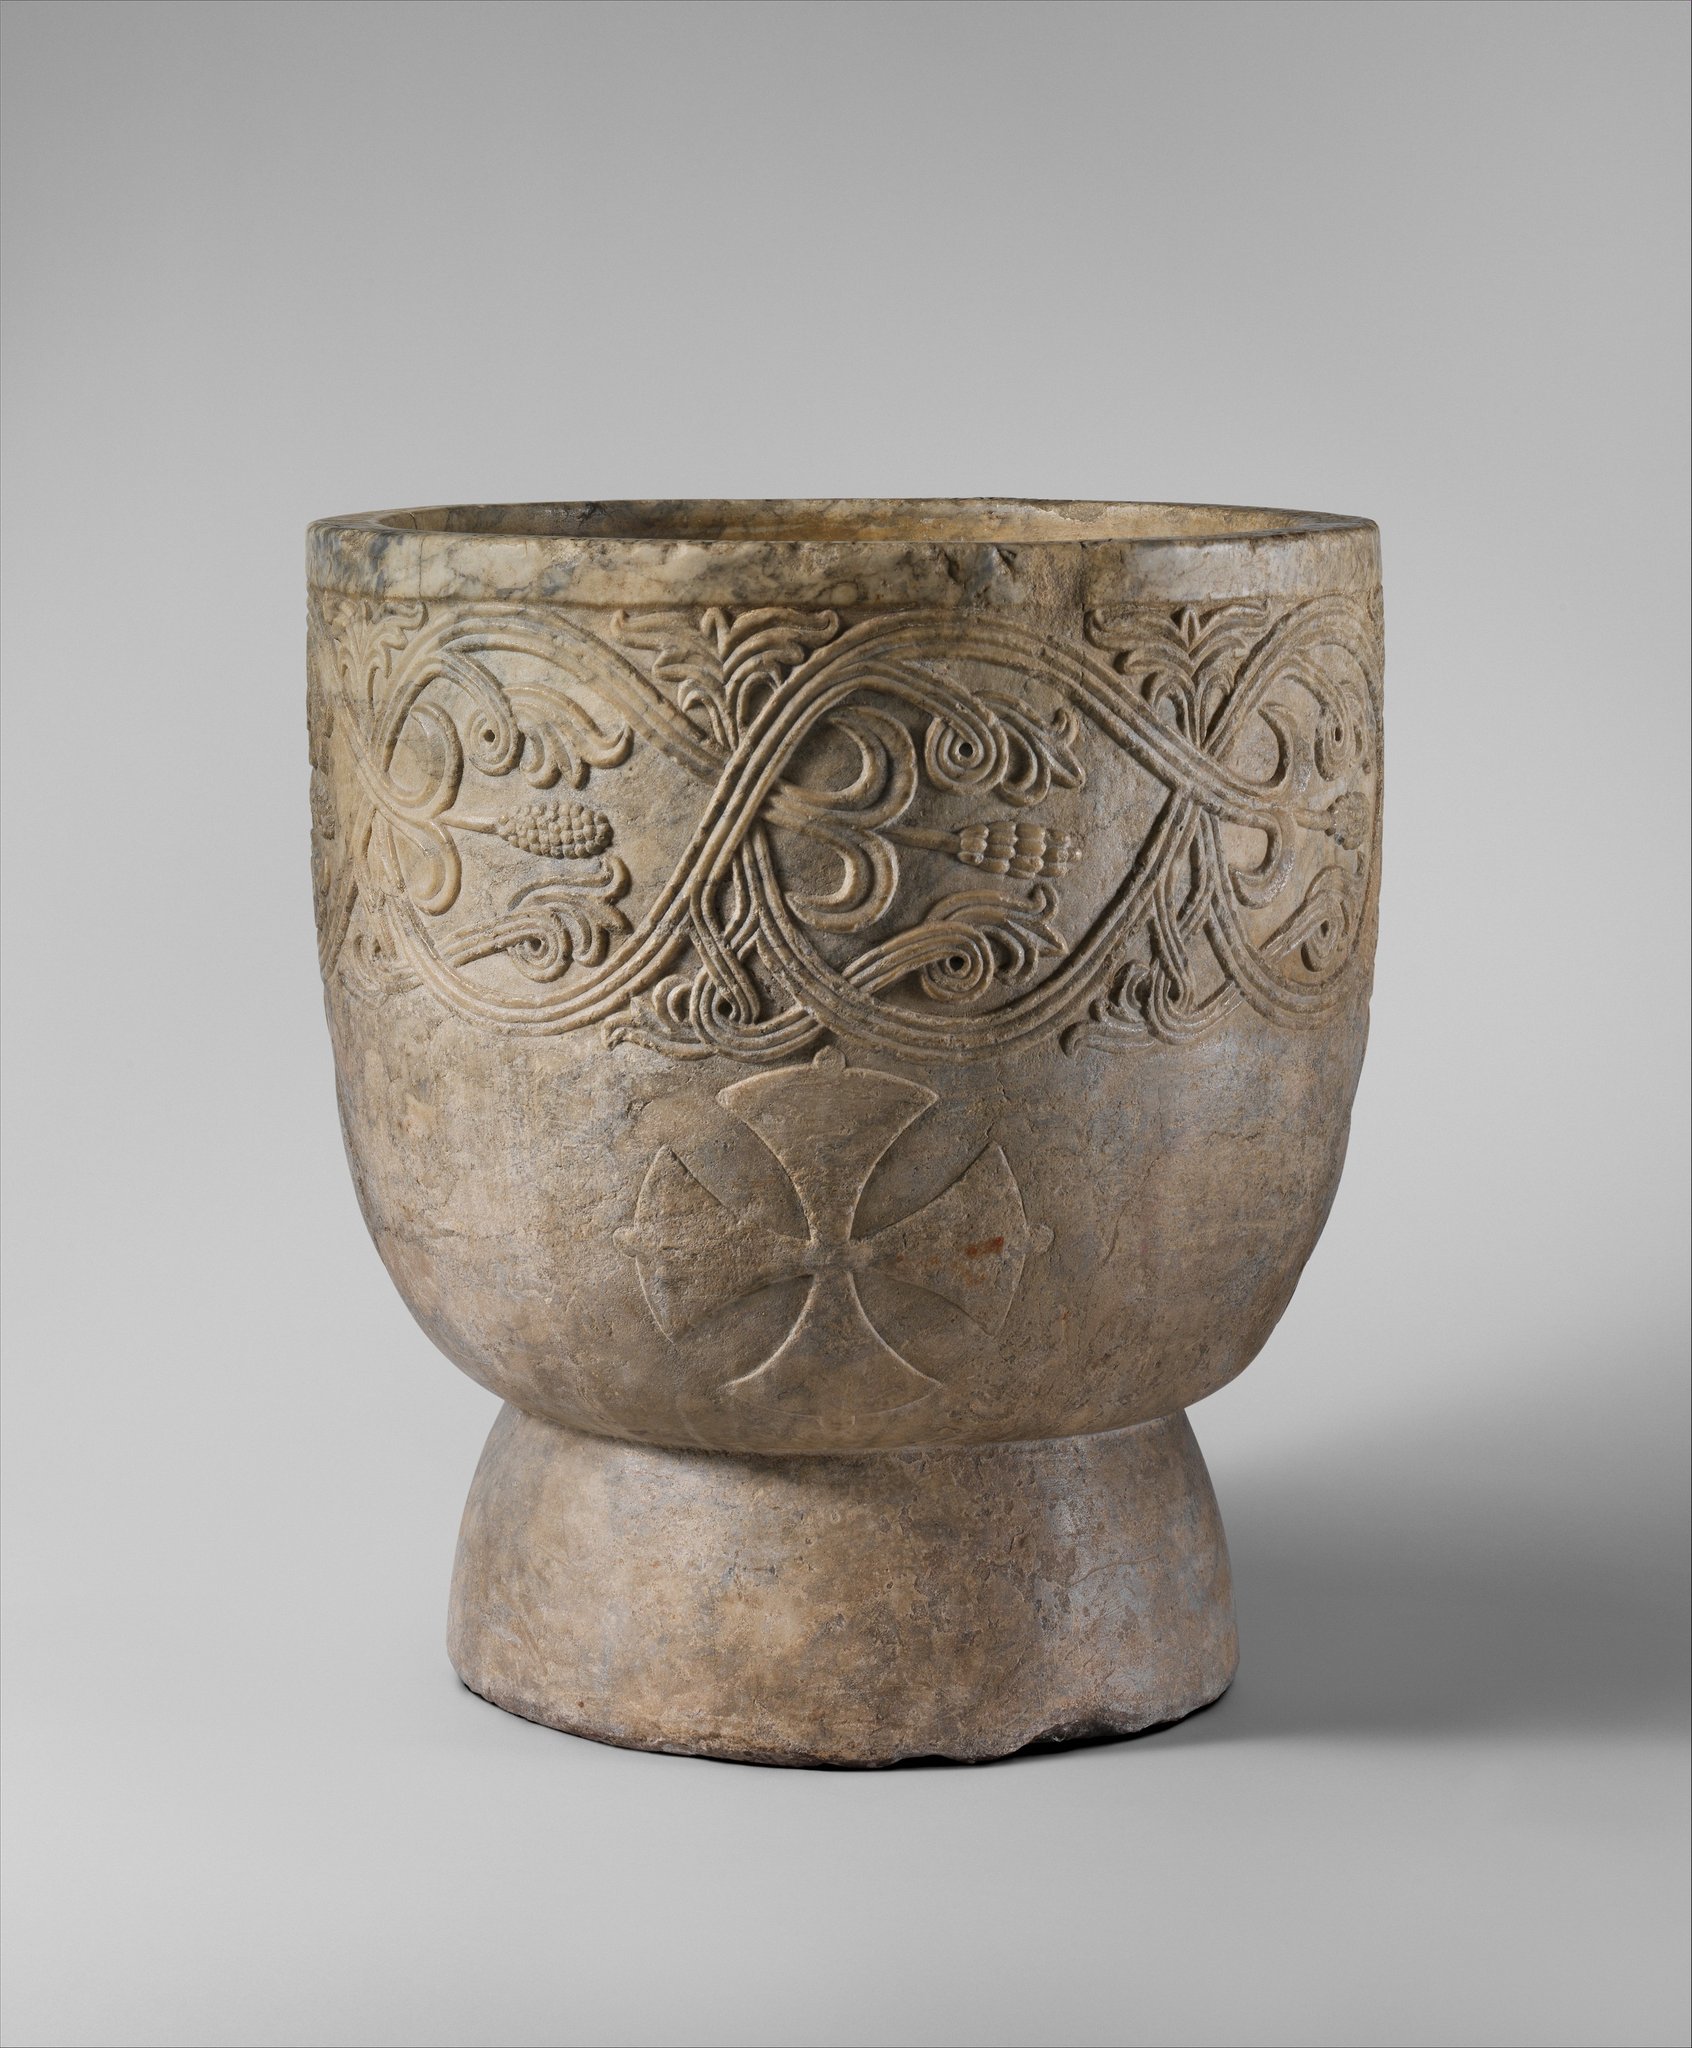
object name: font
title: Baptismal Font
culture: south italian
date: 1137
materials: marble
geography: italy